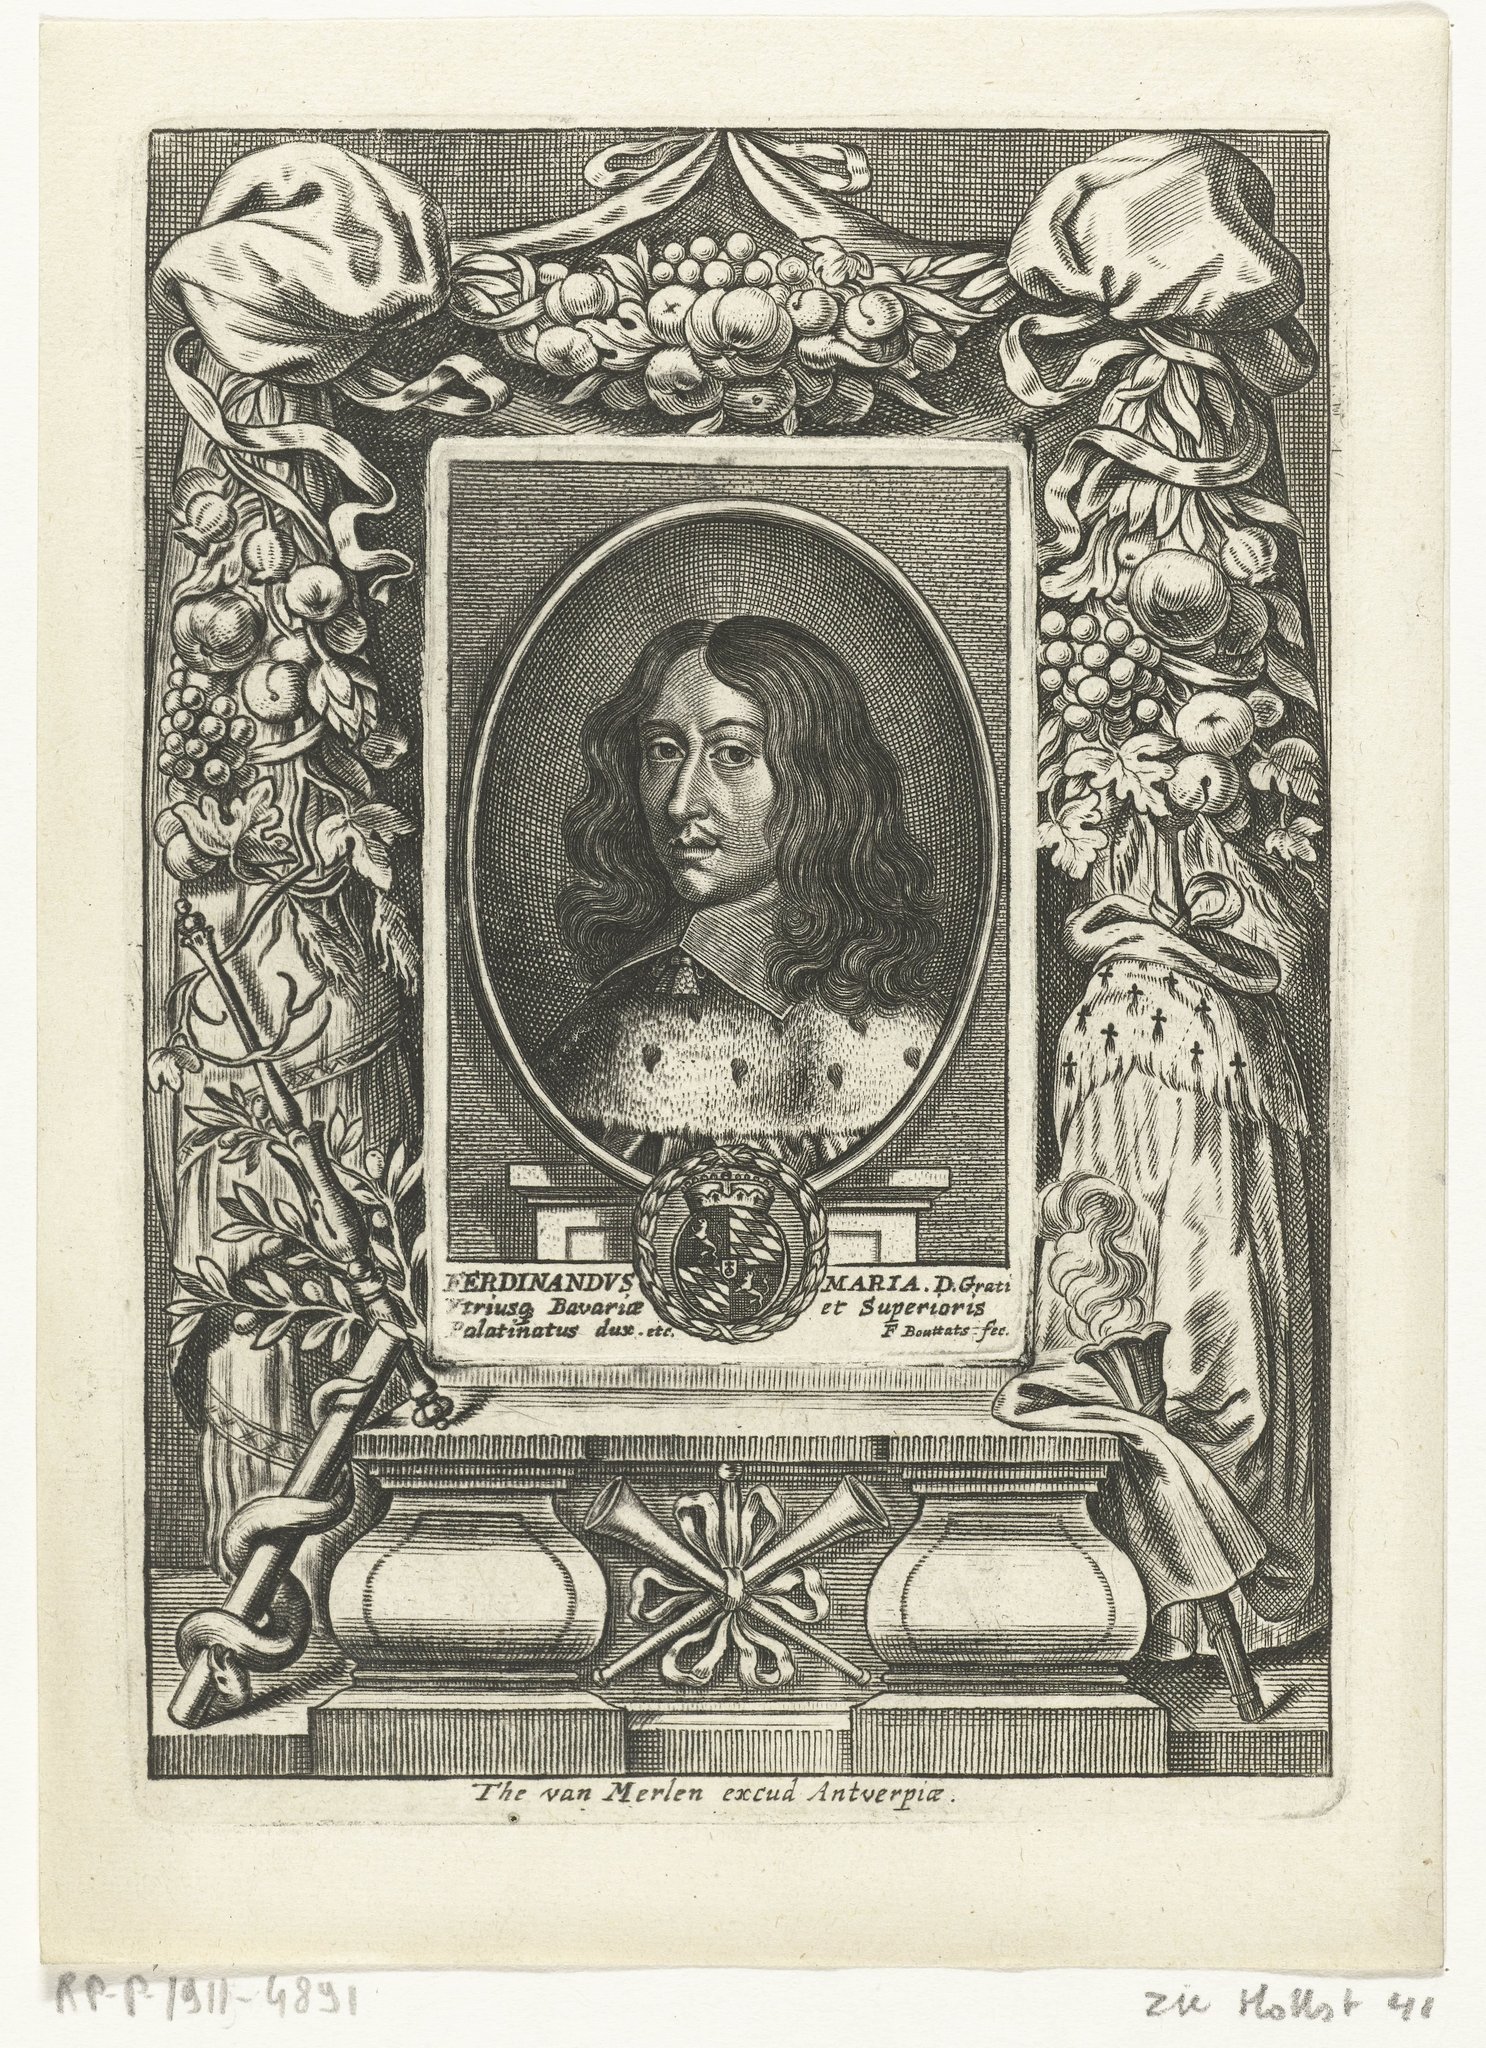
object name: print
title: Portret van Ferdinand Maria van Beieren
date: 1651-1676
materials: paper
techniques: engraving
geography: antwerp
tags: ferdinand maria keurvorst van beieren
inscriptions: collector's mark: Lugt 2228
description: Portret in een ovale lijst van Ferdinand Maria, keurvorst van Beieren. Buste naar links. Ferdinand Maria van Beieren draagt een hermelijnen mantel. Het portret staat in een rechthoekig kader. De prent heeft een Latijns onderschrift met de naam van de geportretteerde.